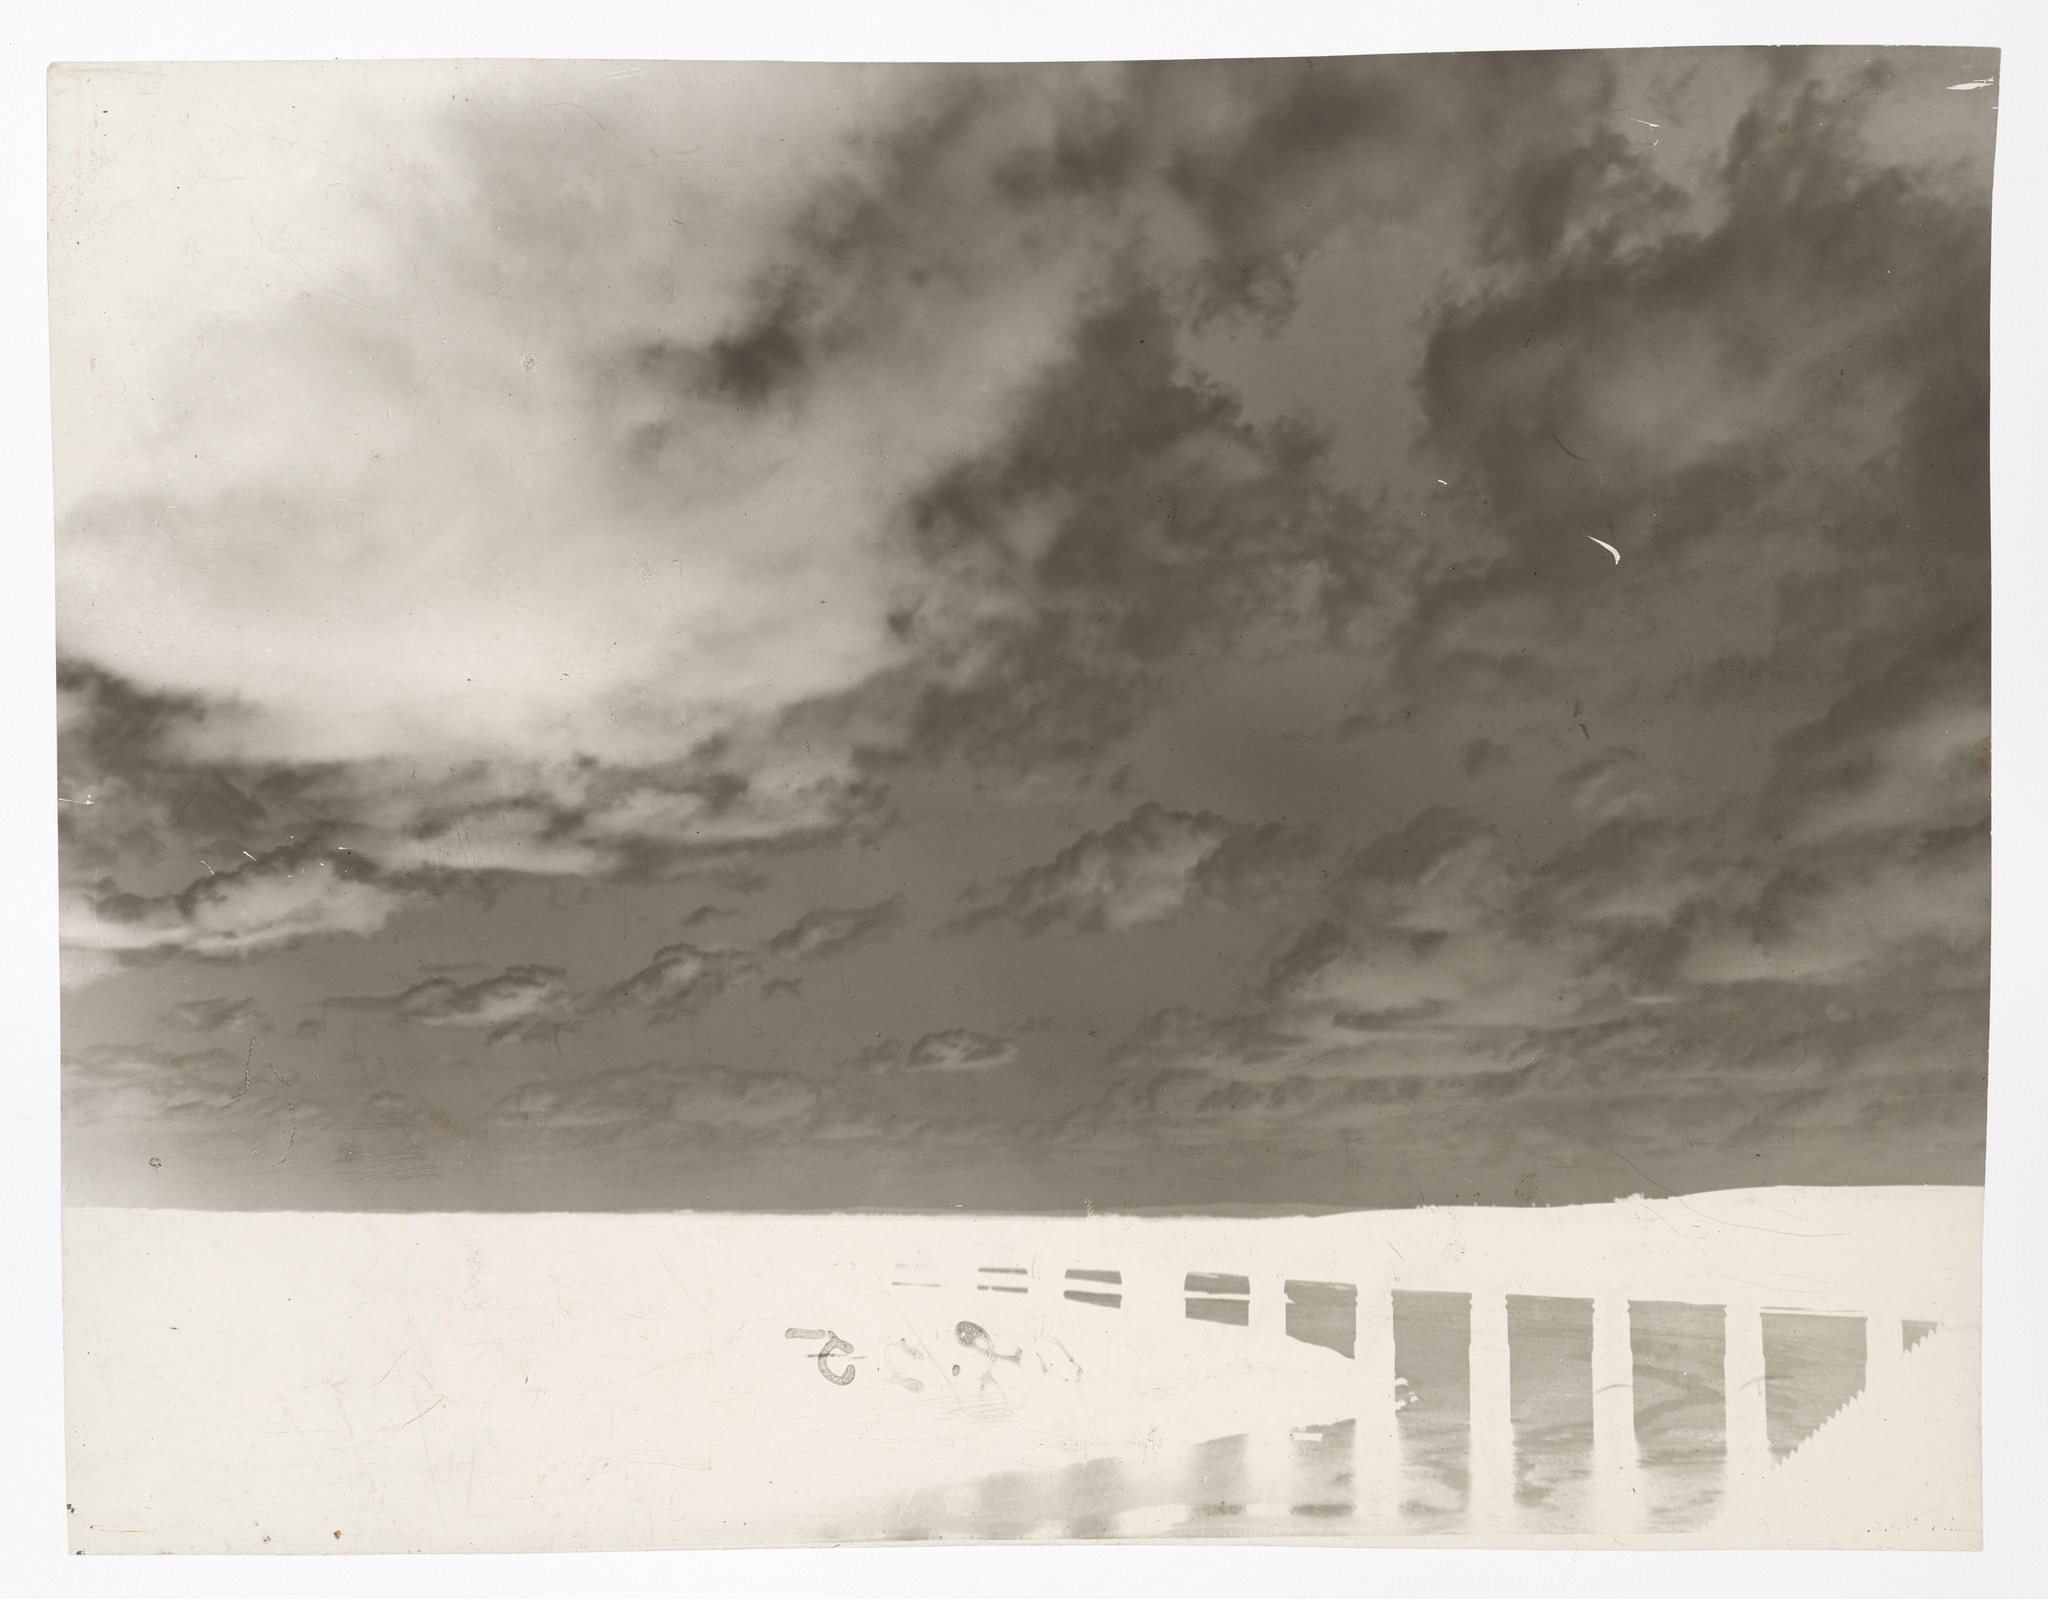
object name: filmnegatief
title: Wolkenlucht boven een brug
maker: Anonymous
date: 1900-1950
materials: plastic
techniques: gelatin silver negative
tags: clouds, landscape with bridge, viaduct or aqueduct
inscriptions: number: ‘log. 25’